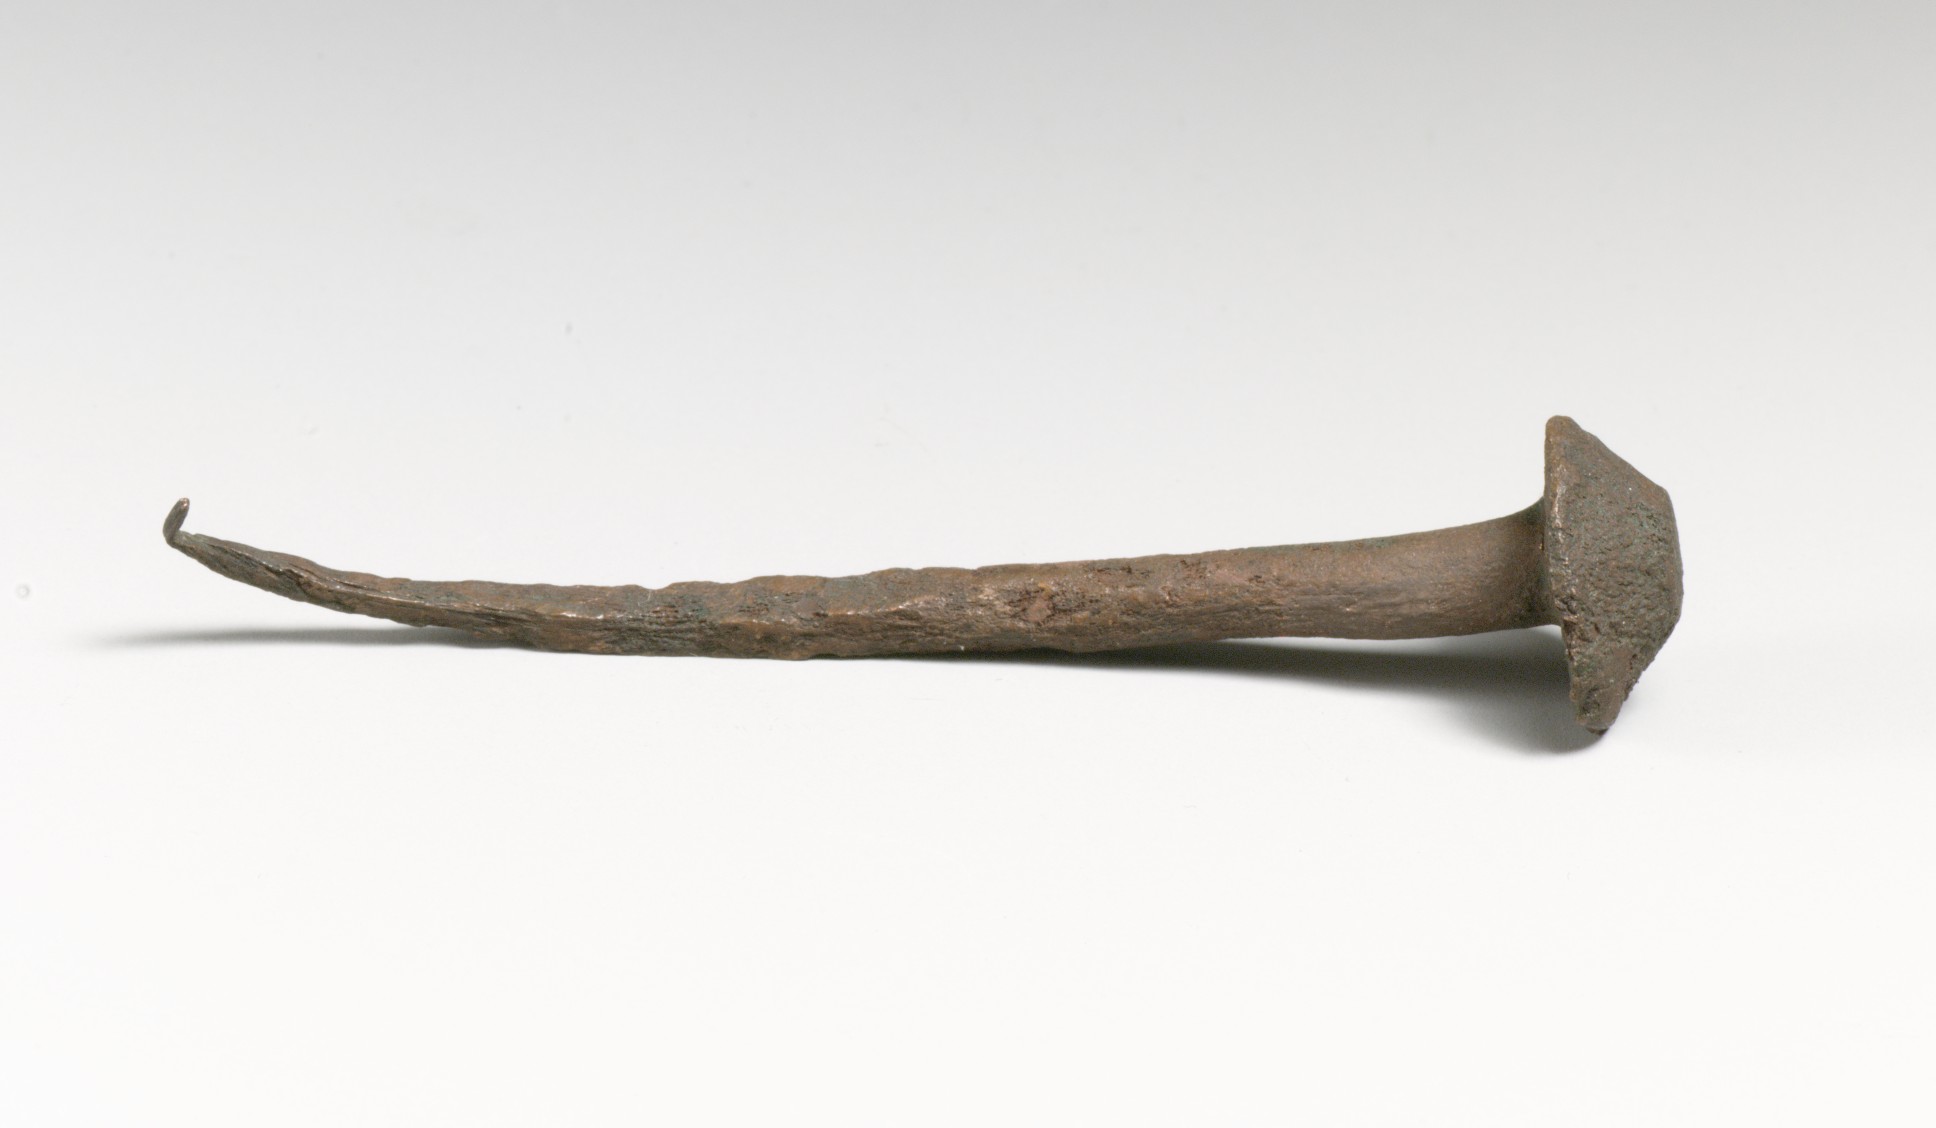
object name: nail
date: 7000 BCE-330 CE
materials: bronze